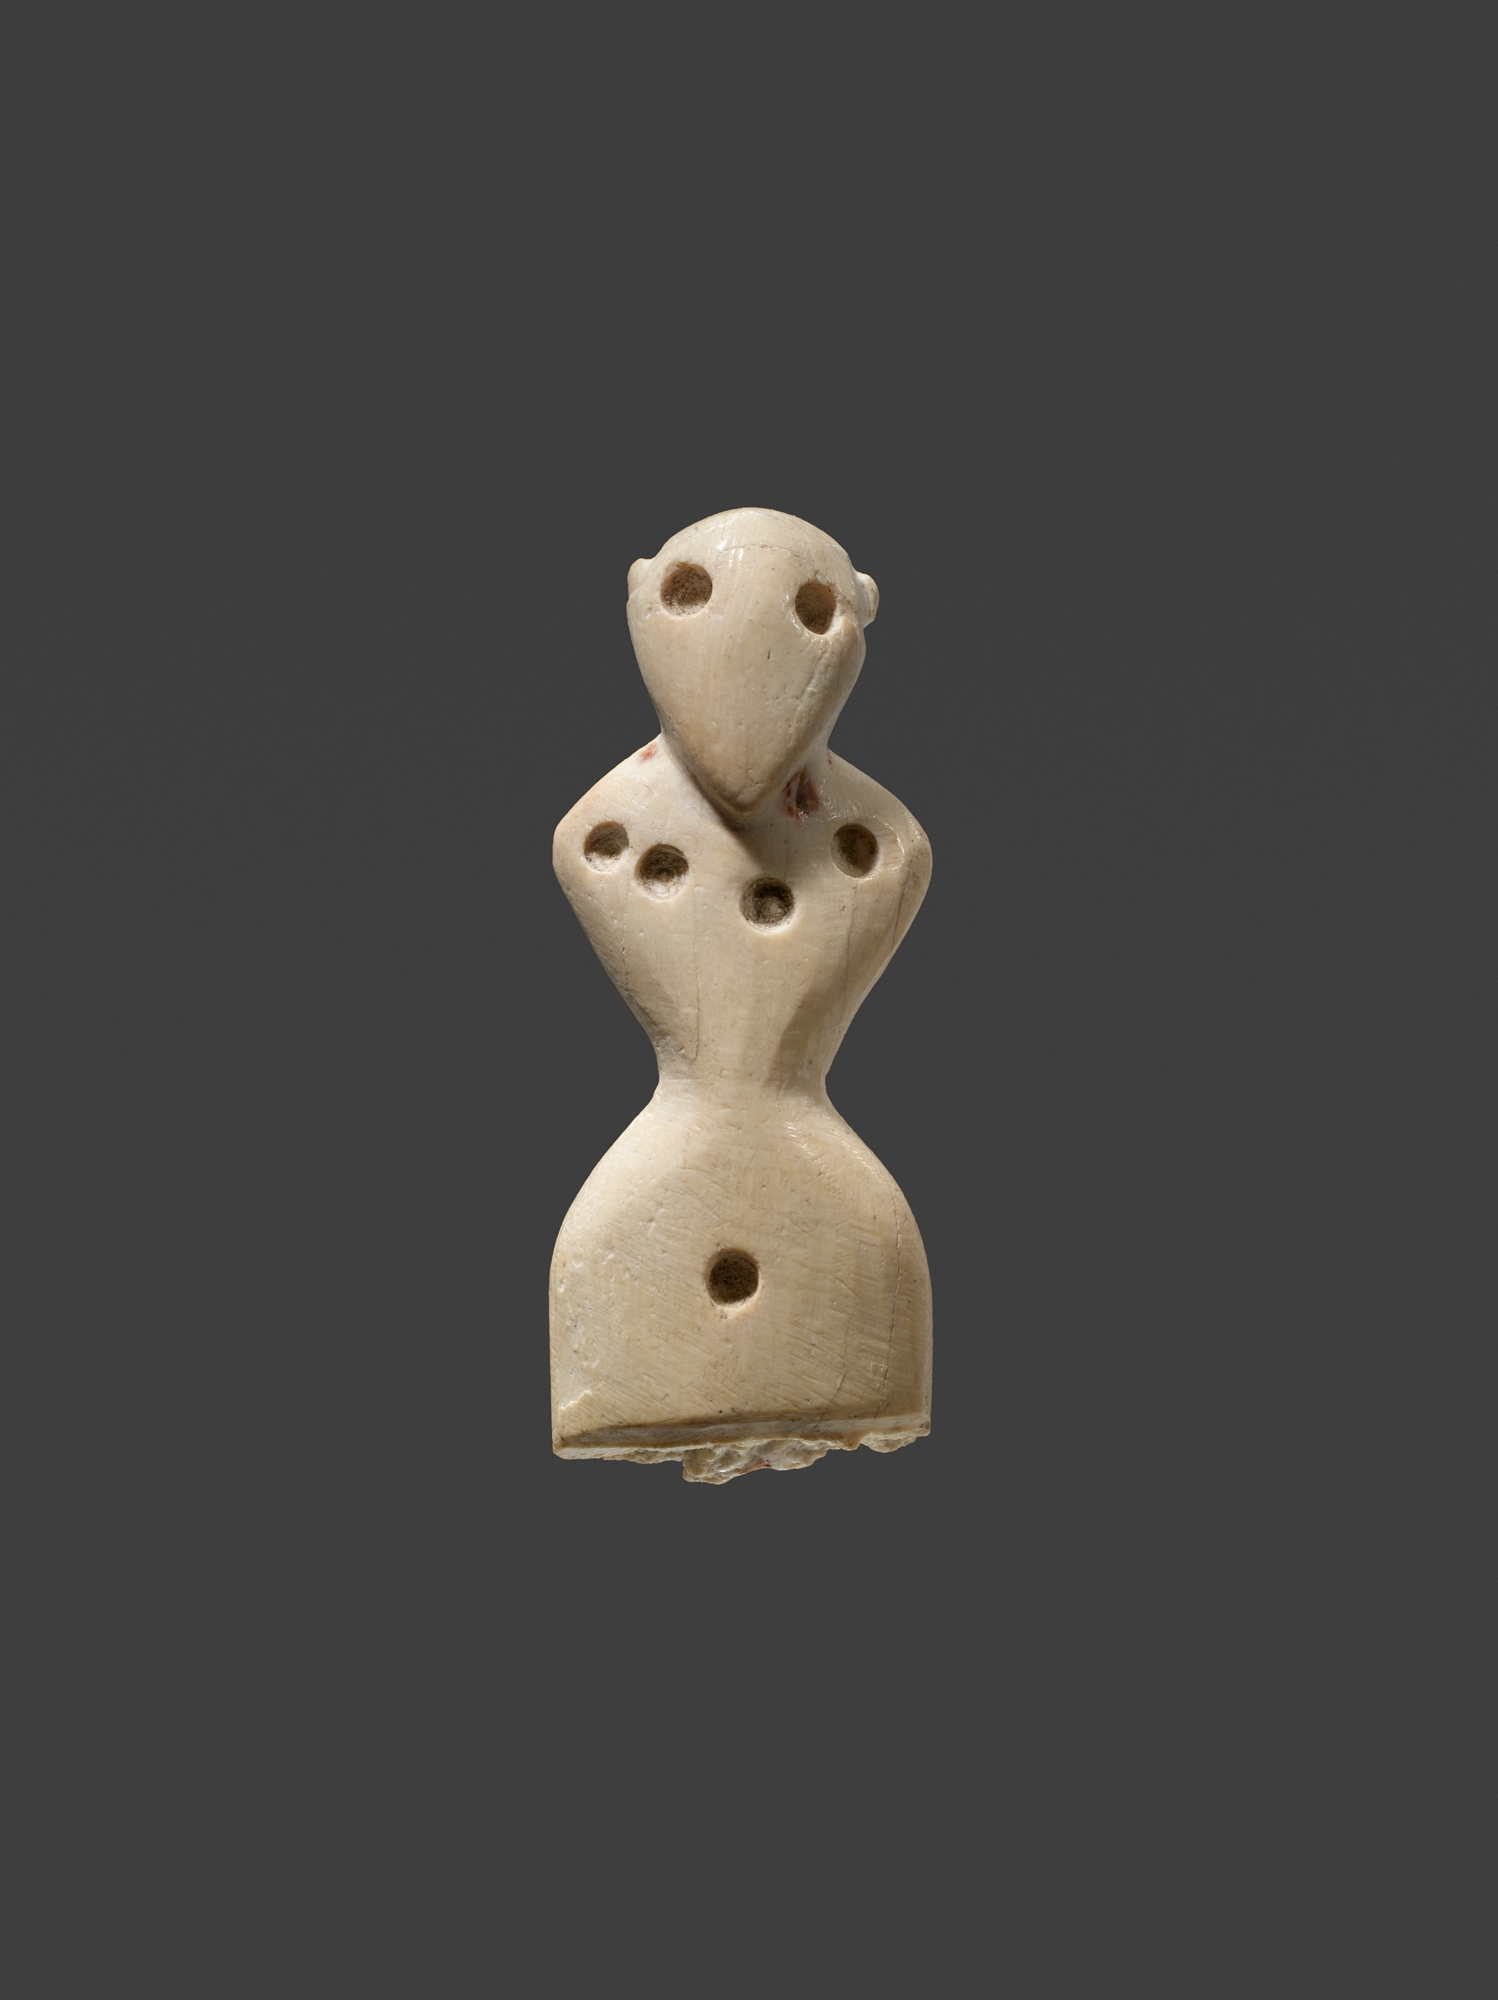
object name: statuette, female, necklace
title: Female figurine wearing necklace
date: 3500-3300 BCE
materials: bone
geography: egypt